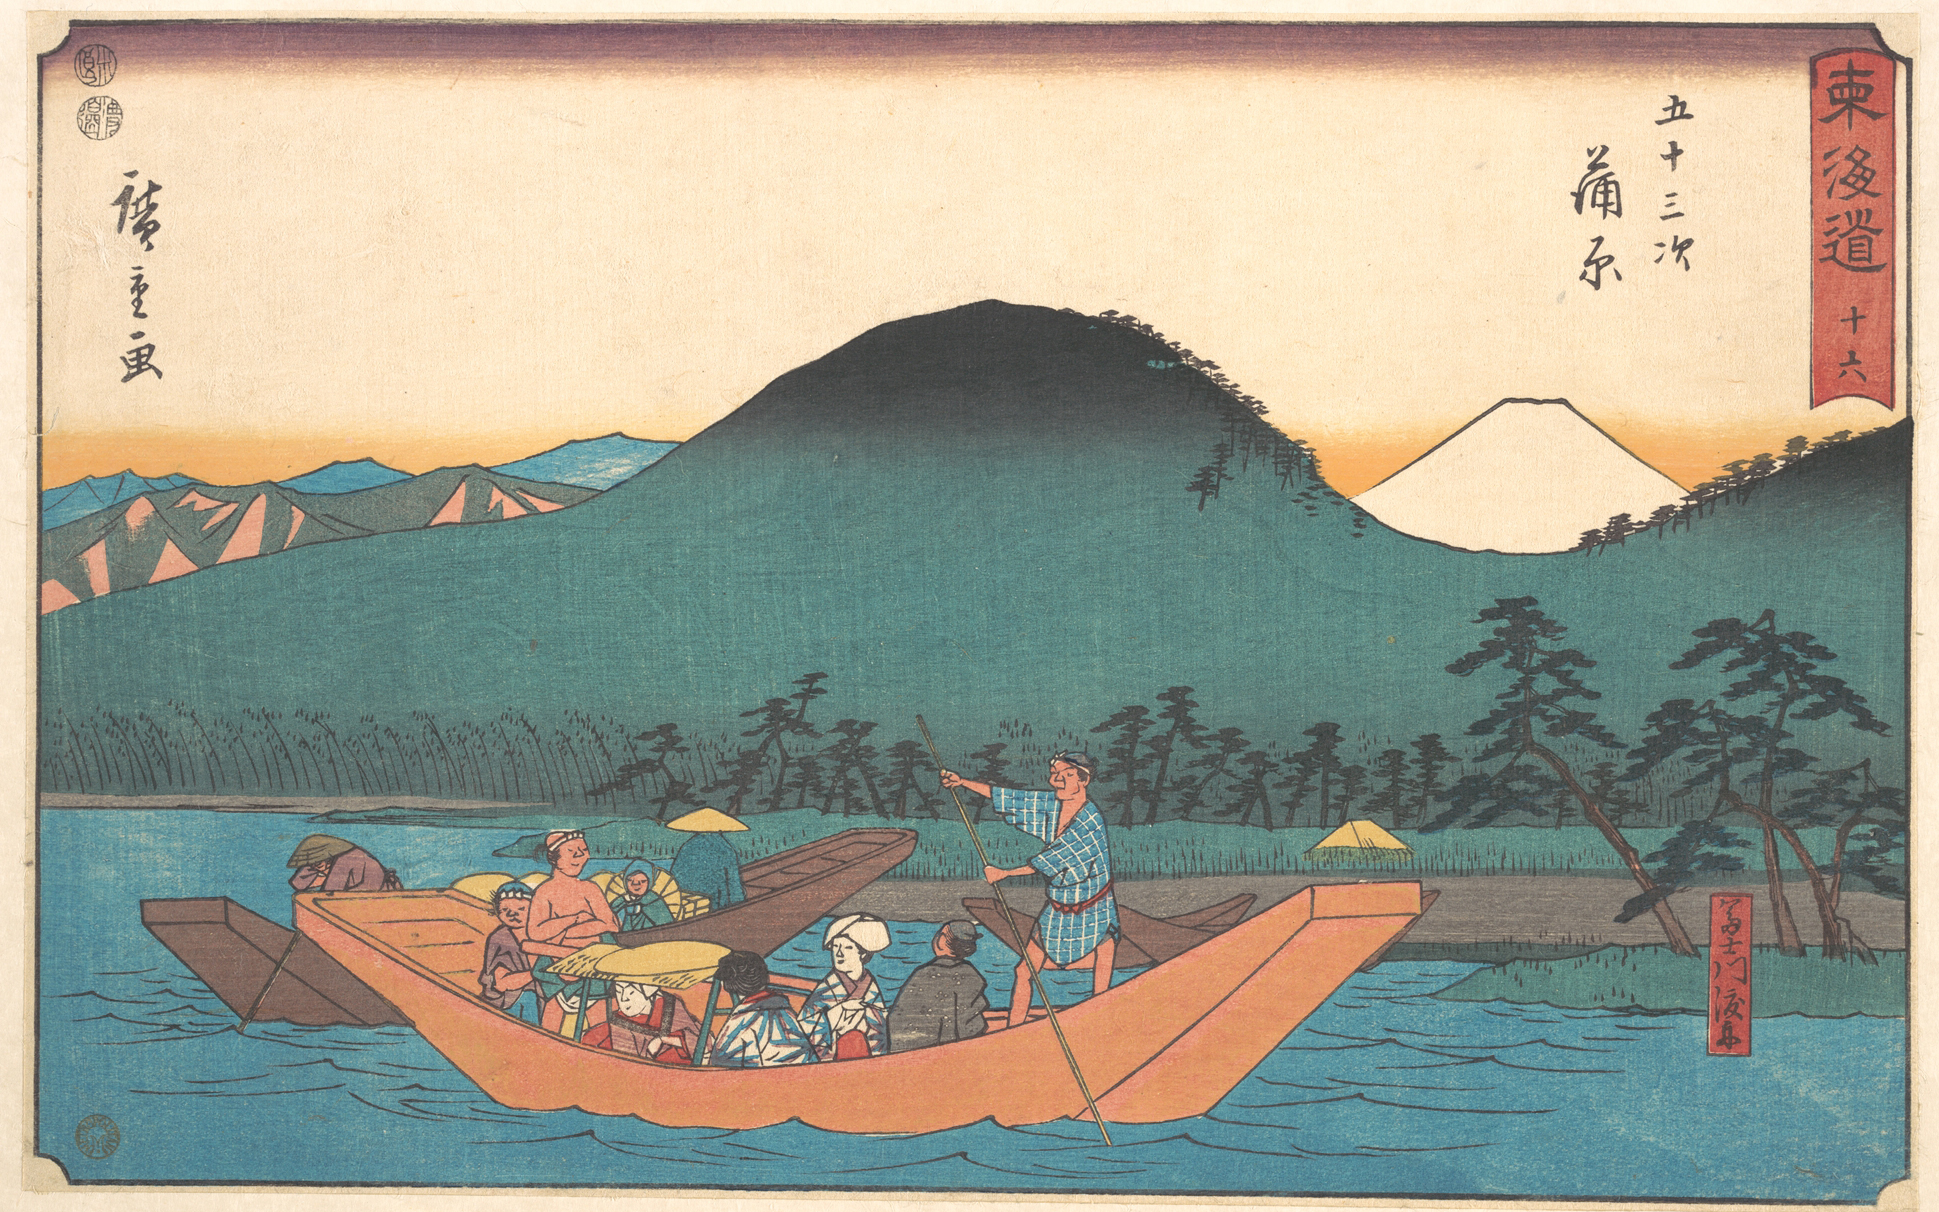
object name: woodblock print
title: Kambara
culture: japanese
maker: utagawa hiroshige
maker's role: artist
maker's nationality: japanese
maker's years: 1797-1858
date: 1840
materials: ink, paper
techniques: woodblock print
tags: men,rivers,mountains,trees,boats